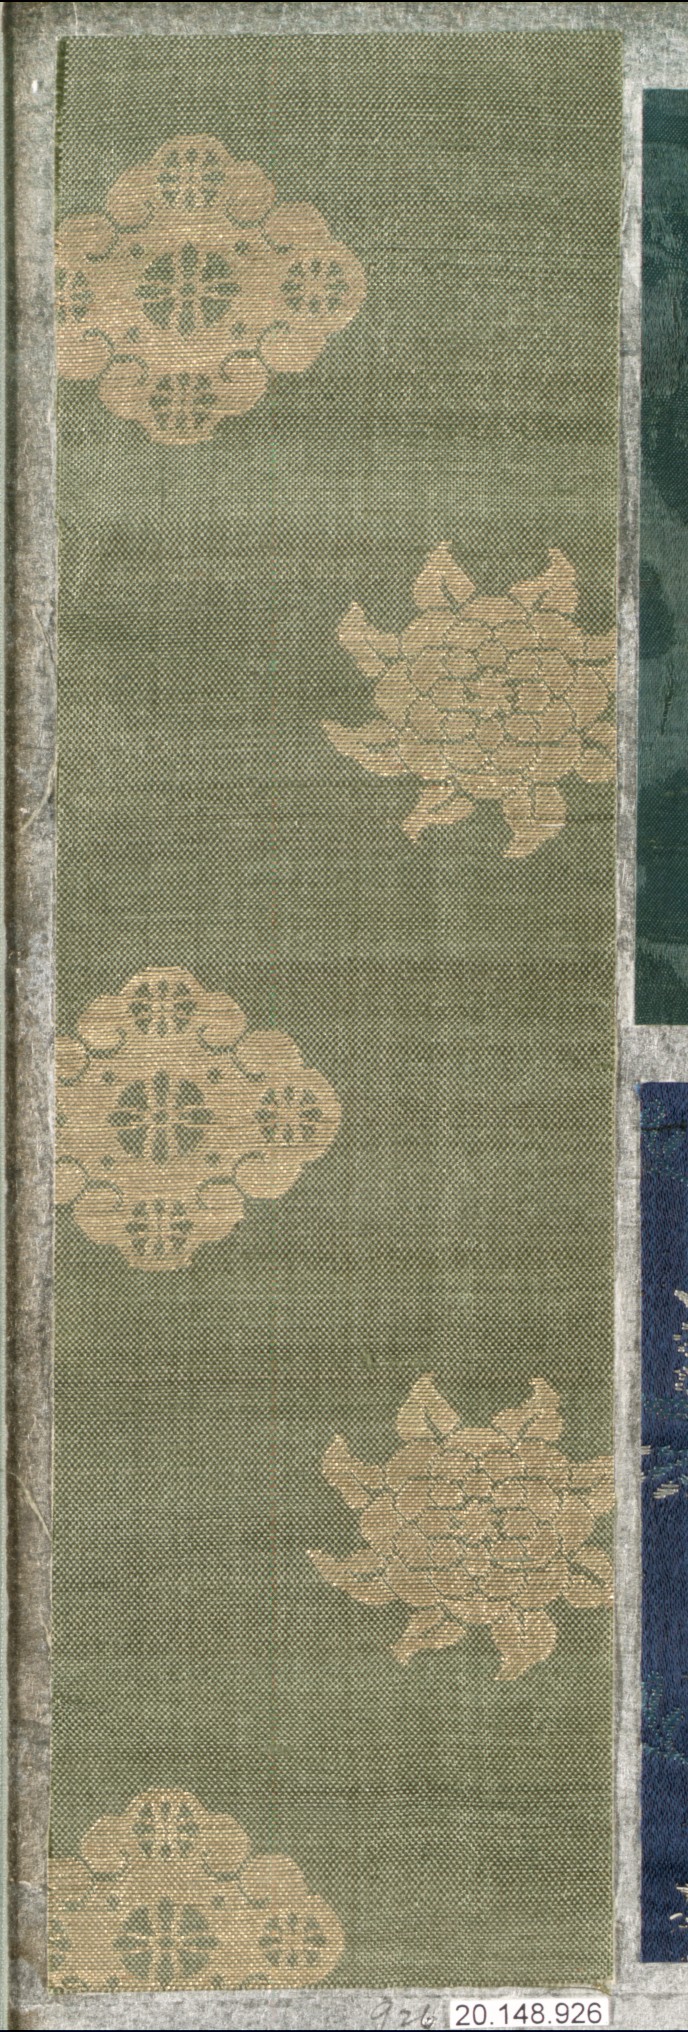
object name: piece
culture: japanese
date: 1701-1800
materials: silk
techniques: compound weave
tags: flowers